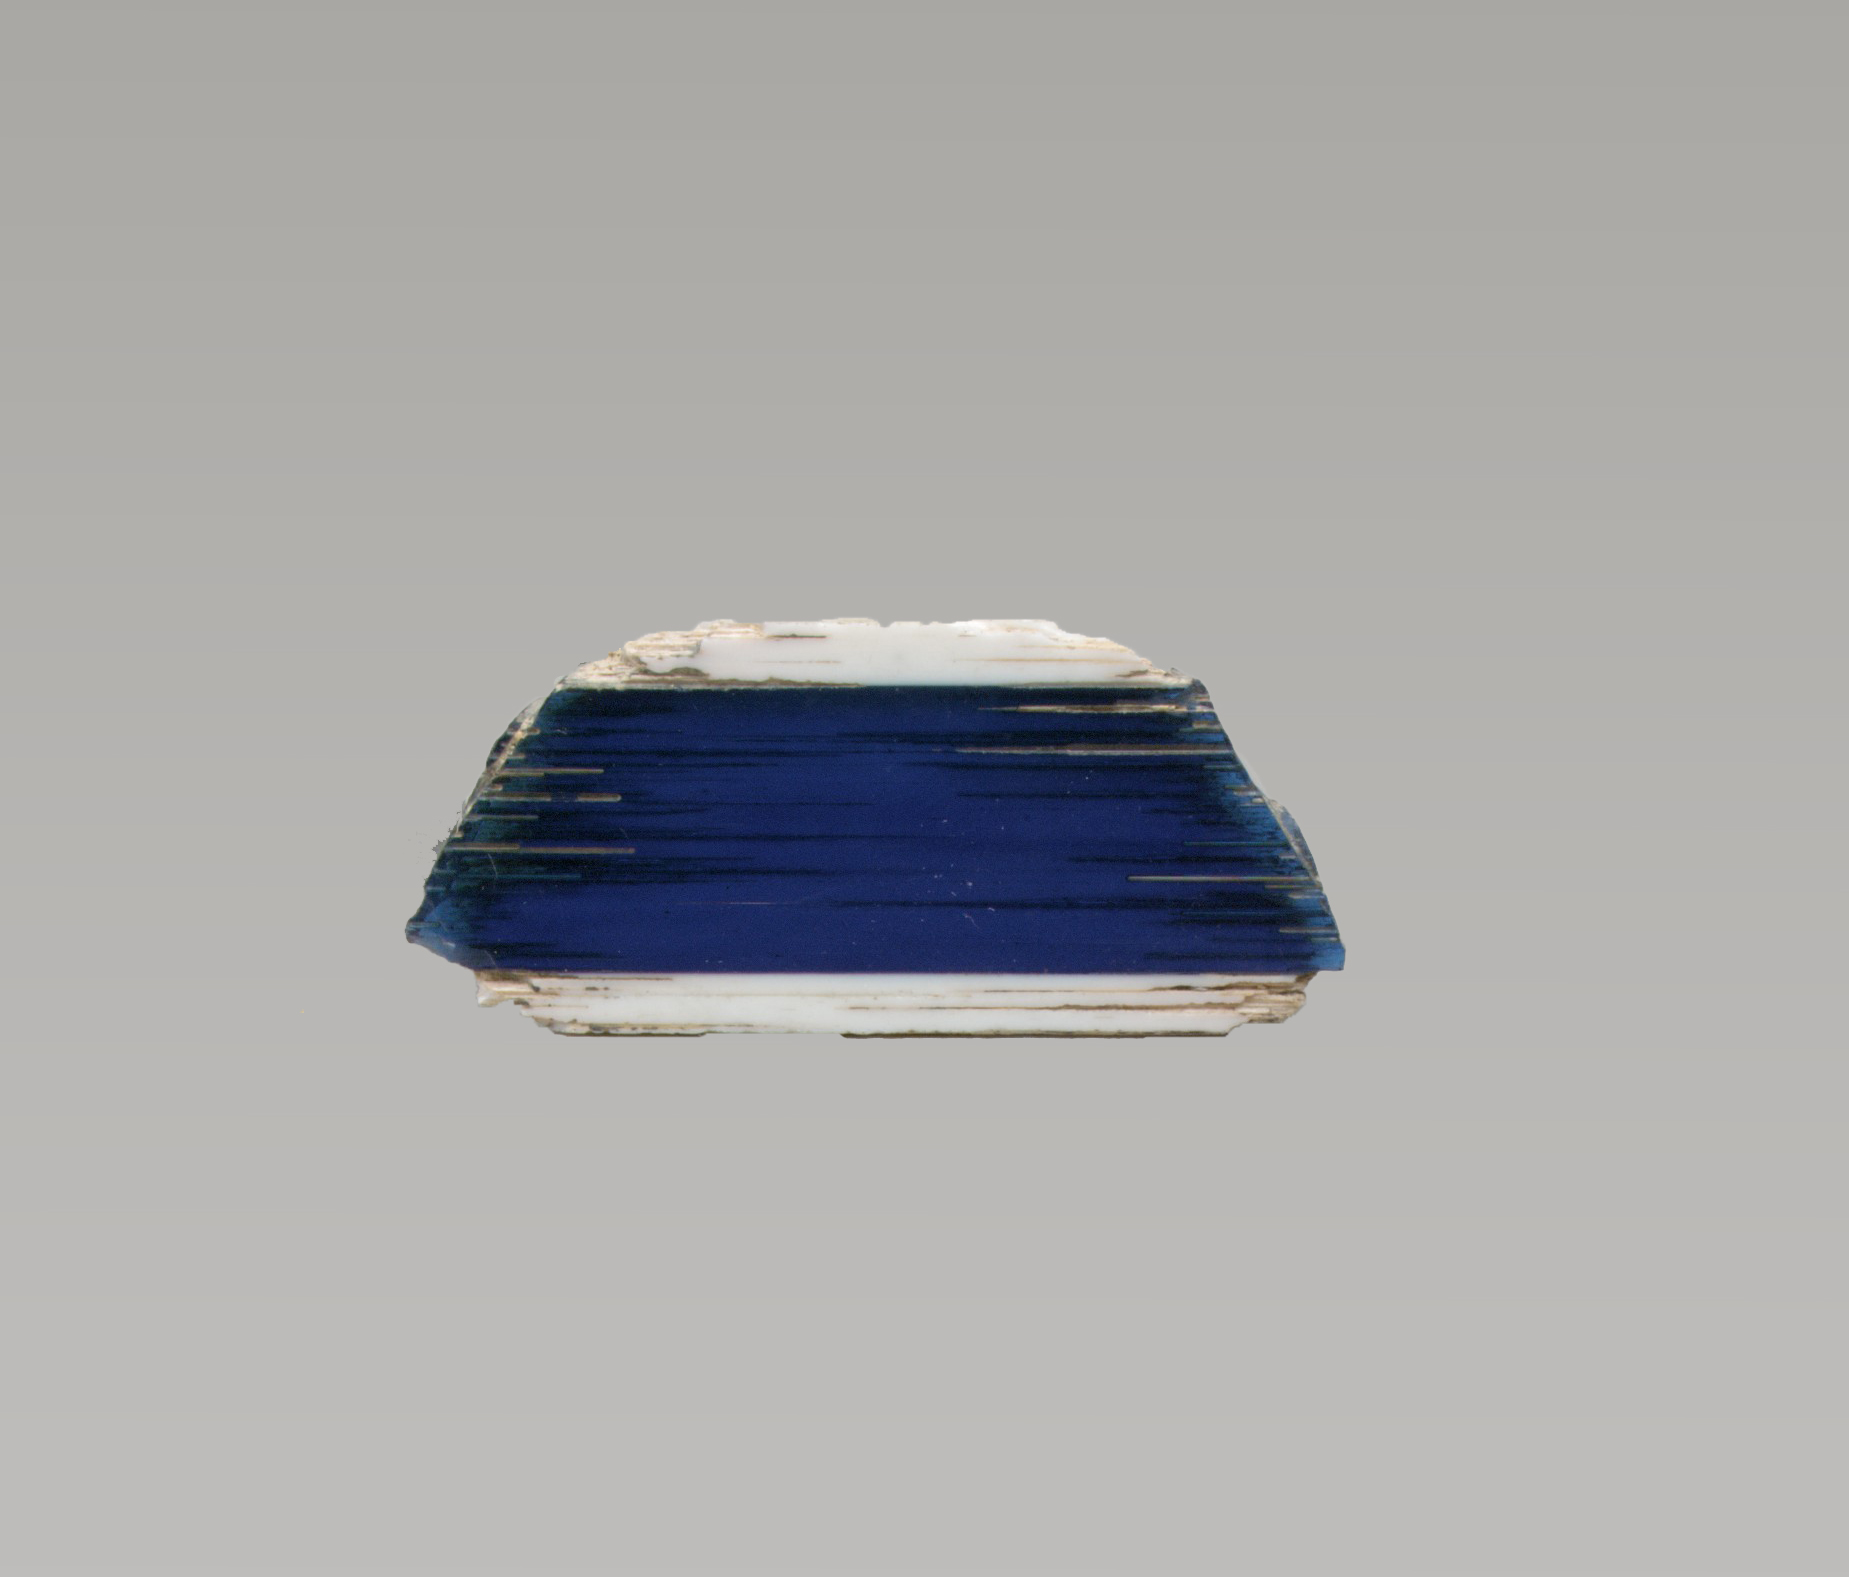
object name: fragment, inlay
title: Glass inlay fragment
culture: roman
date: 1-50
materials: glass